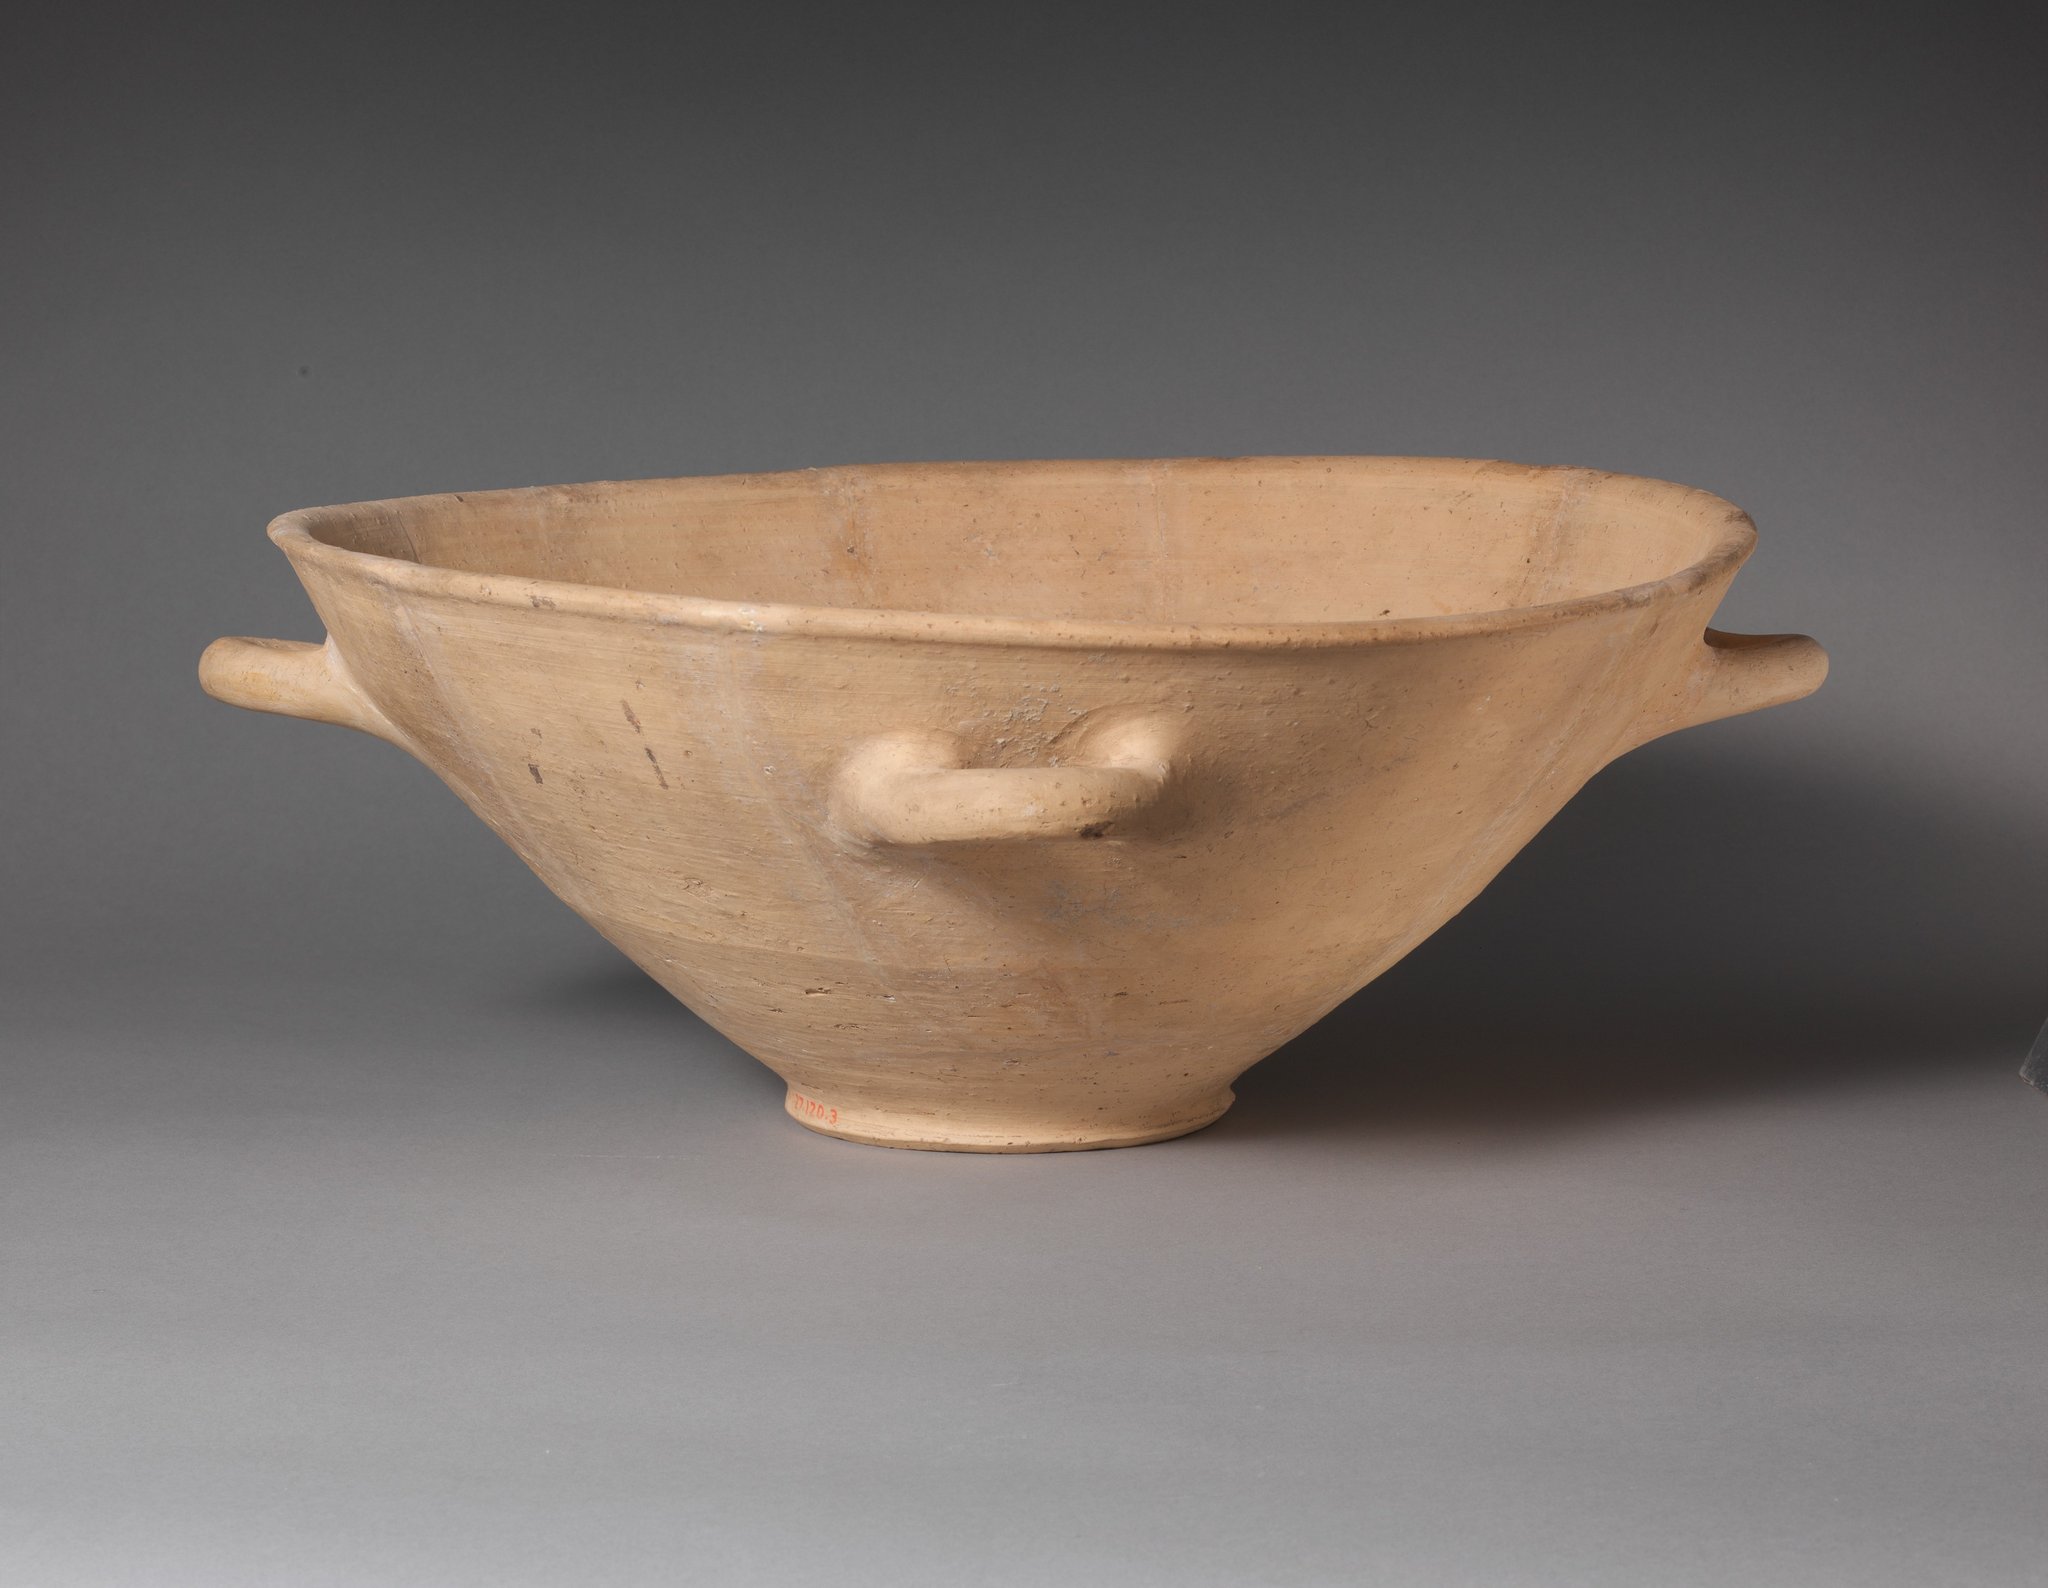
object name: basin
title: Terracotta basin with four handles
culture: mycenaean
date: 1400-1190 BCE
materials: terracotta